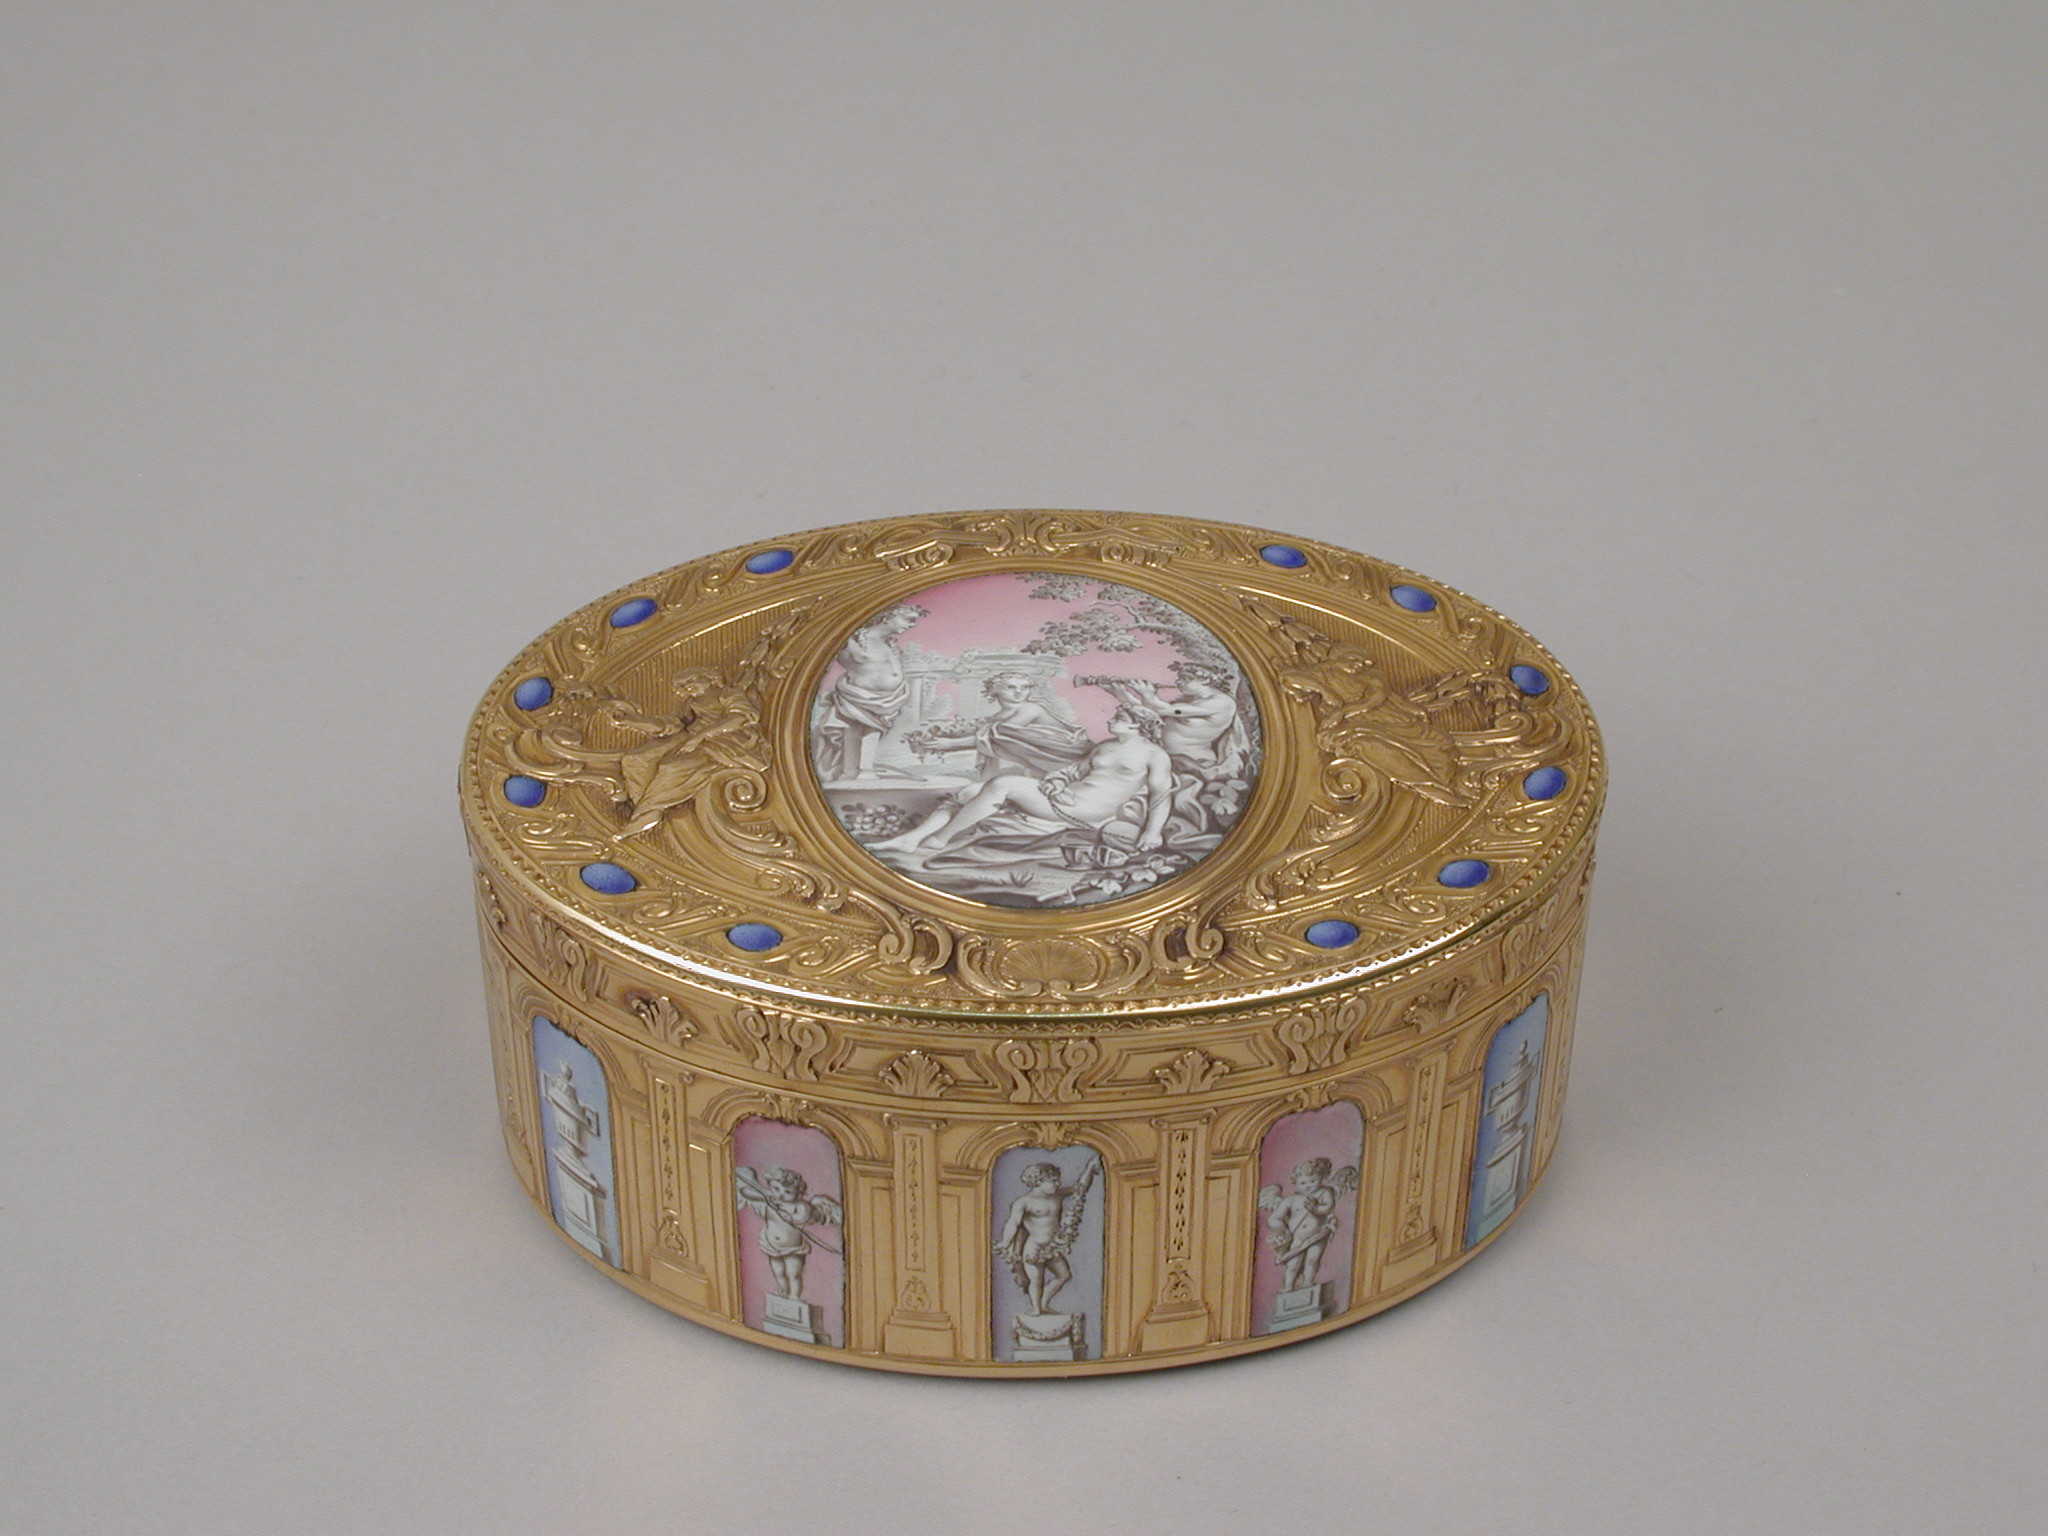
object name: snuffbox, painting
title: Snuffbox with grisaille decoration of Cupid and Venus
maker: jean-baptiste carnay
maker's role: maker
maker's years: 1734-1823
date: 1766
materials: enamel, gold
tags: cupid,venus